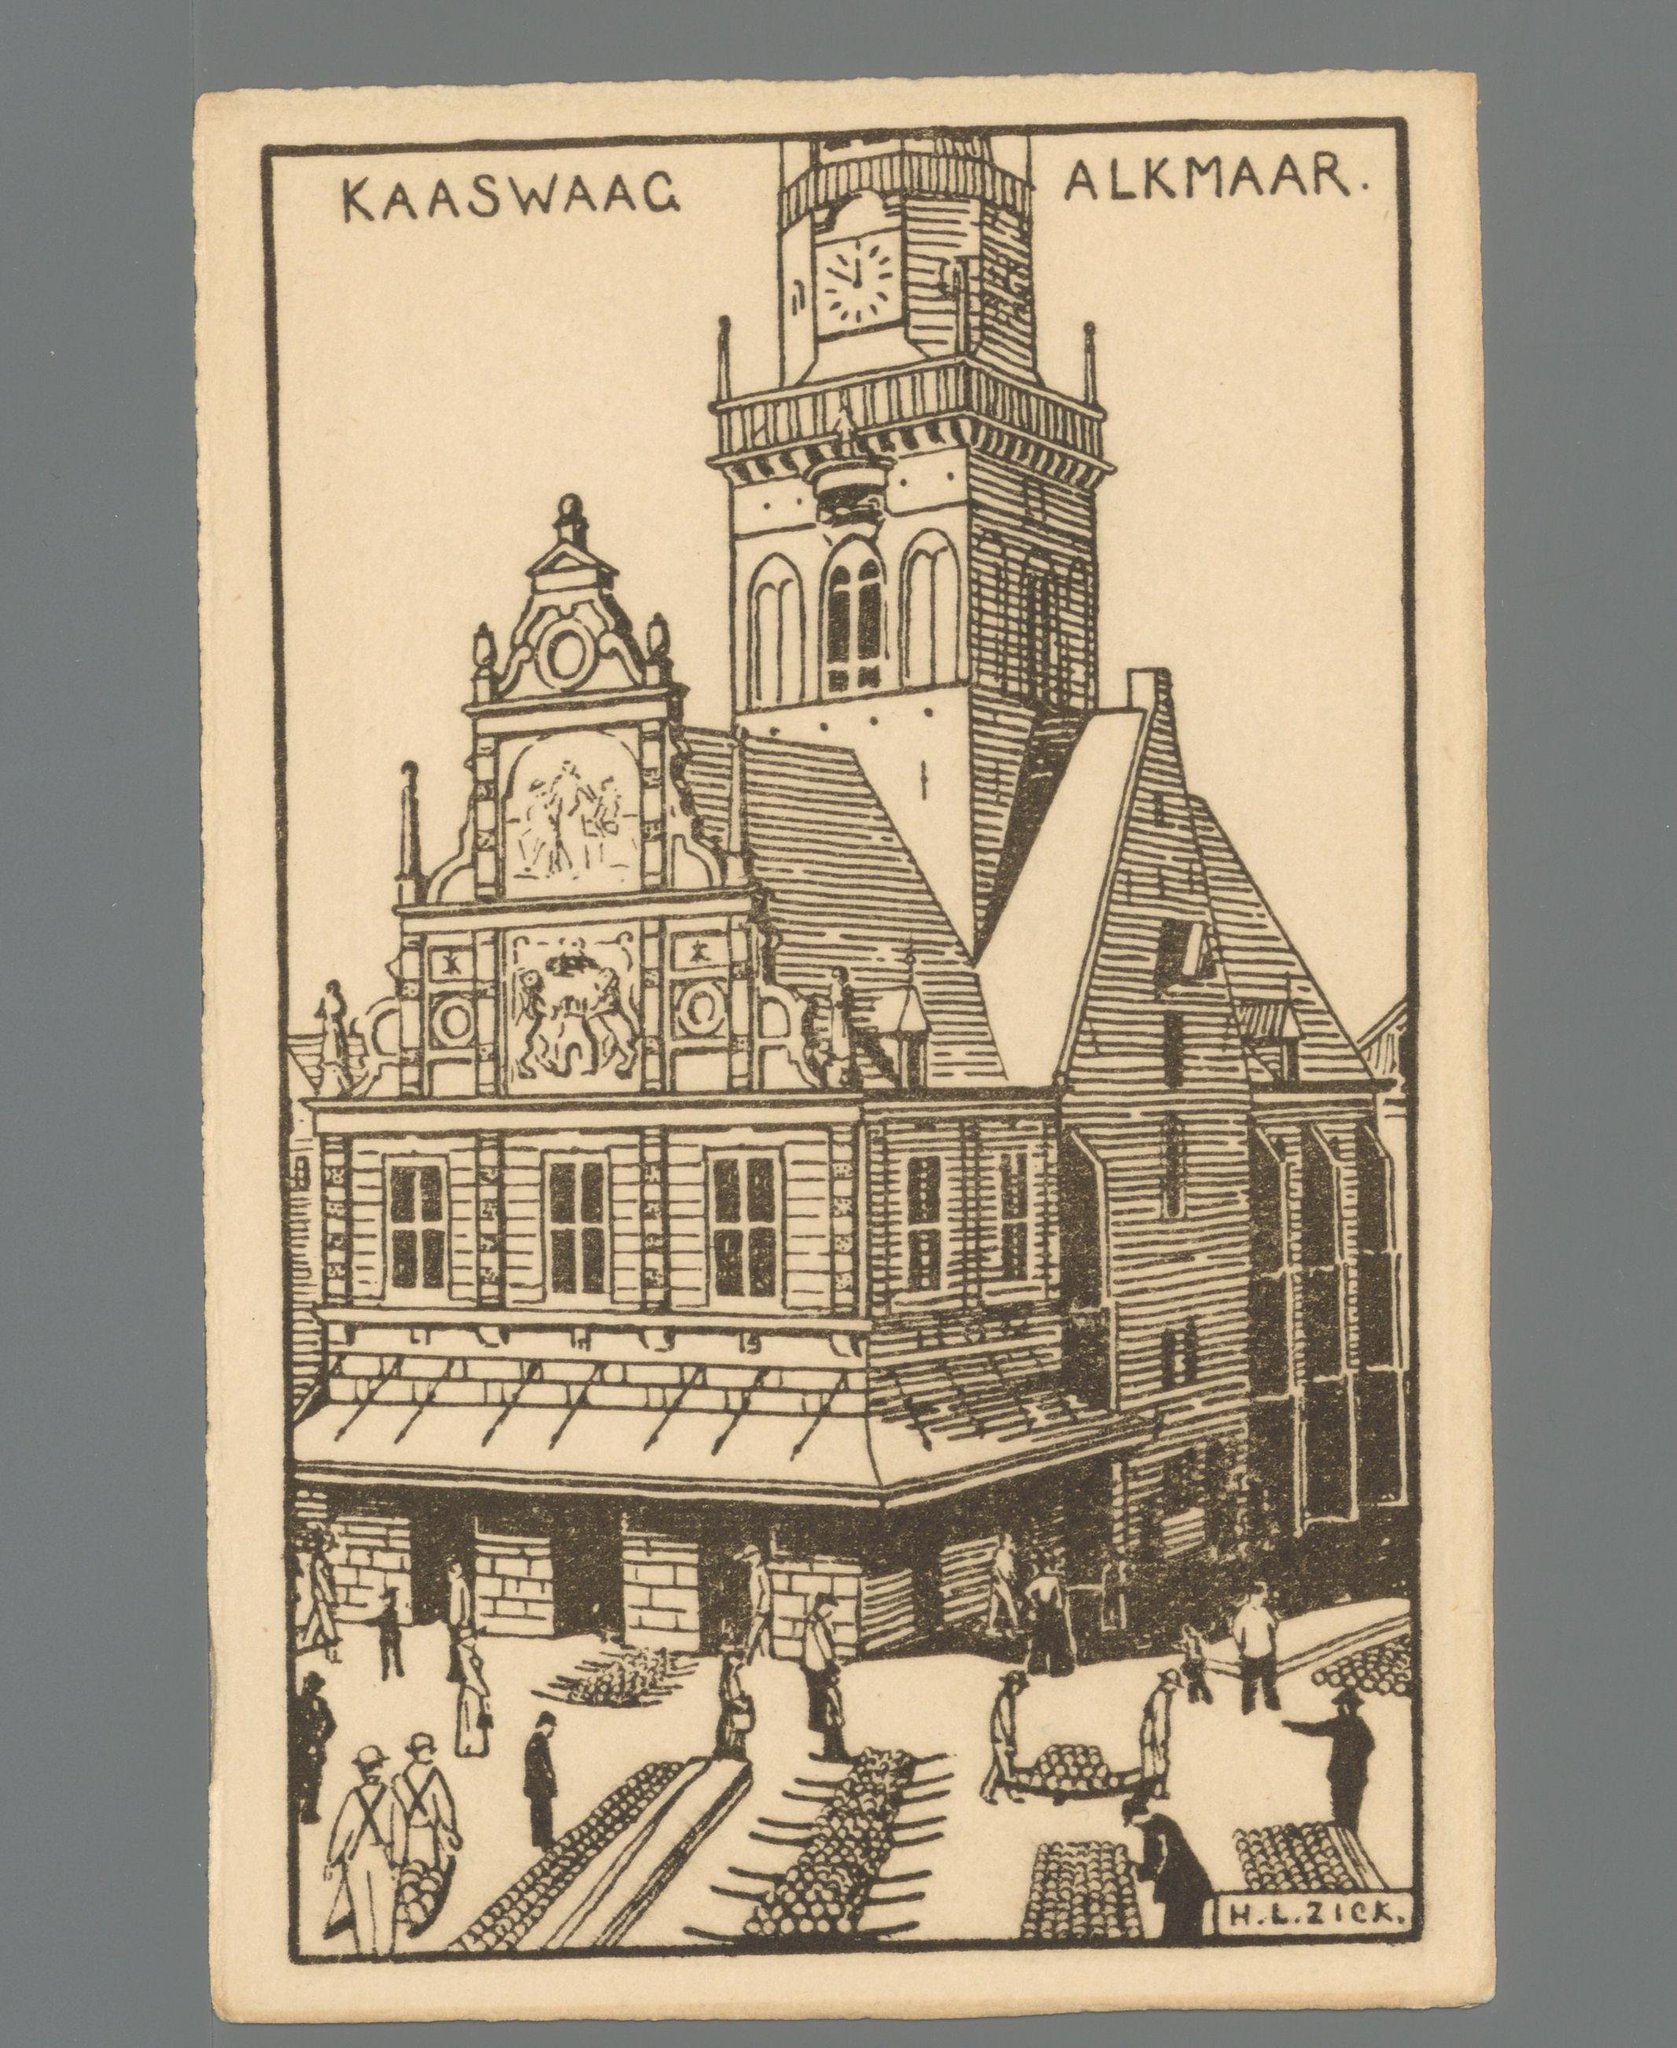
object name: ansichtkaart, prentbriefkaart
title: Kaaswaag, Alkmaar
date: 1905-1940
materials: cardboard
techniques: printing block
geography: alkmaar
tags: tower, clock tower ~ monumental adornment, market, cheese